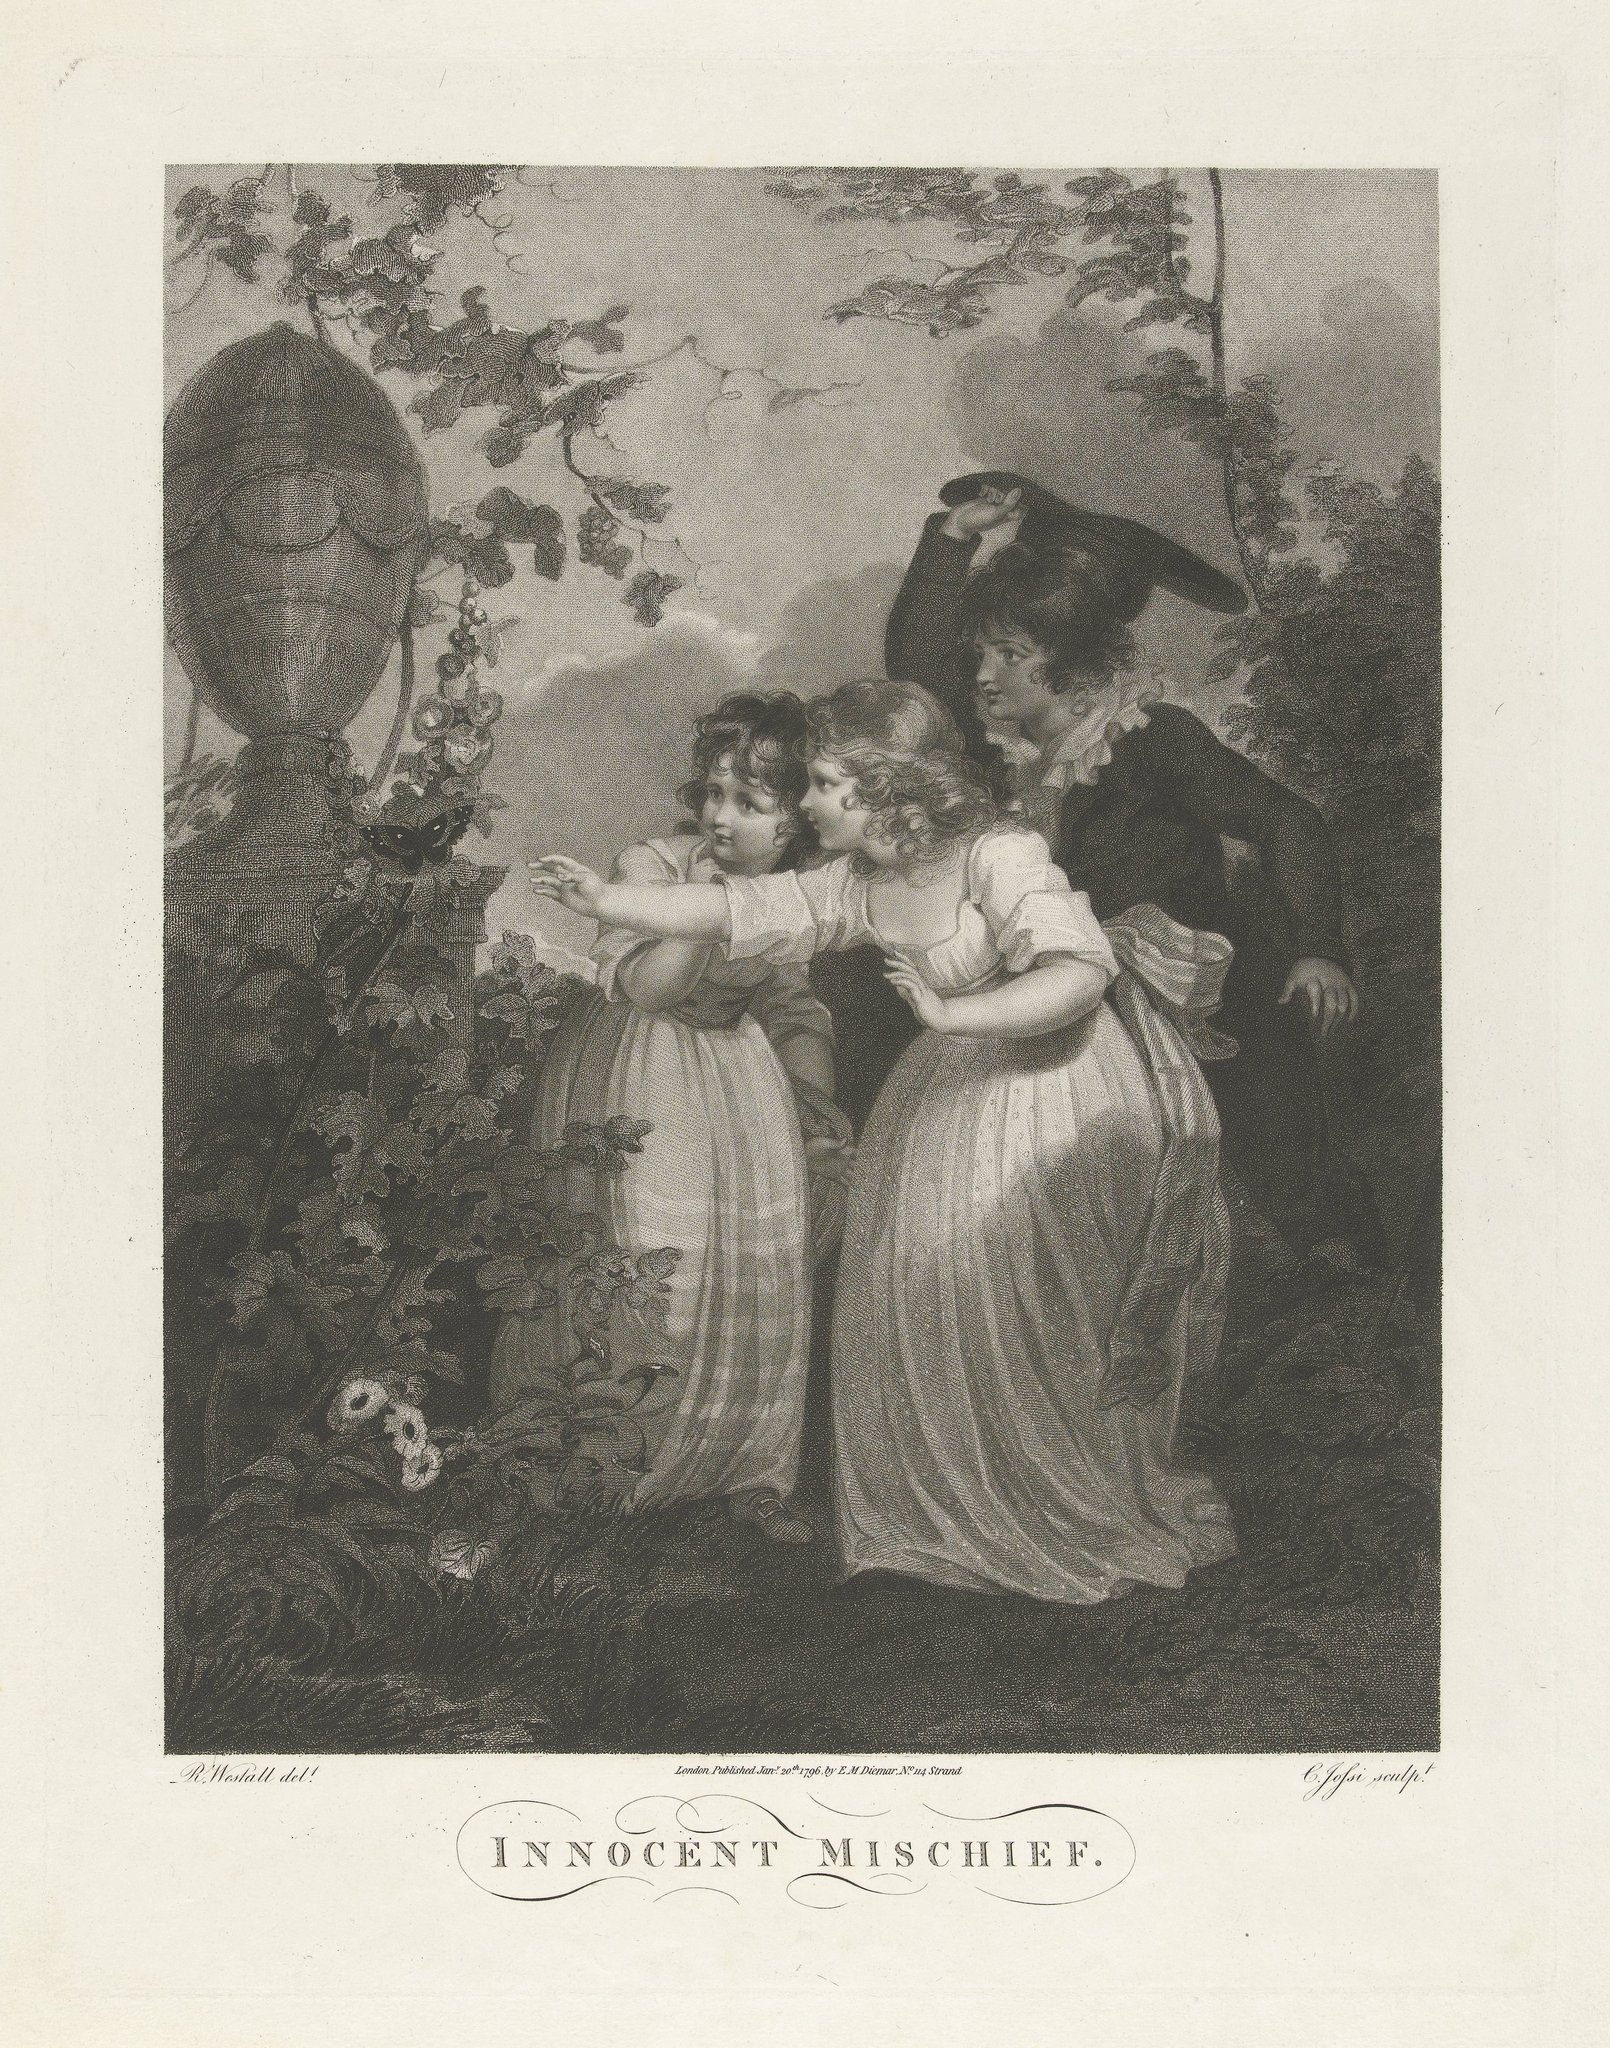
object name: print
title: Tuin met ondeugende kinderen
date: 1796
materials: paper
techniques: engraving, etching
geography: london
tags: mischief-making play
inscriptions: collector's mark: Lugt 2233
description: Een meisje probeert een vlinder te pakken, een ander meisje kijkt toe. Een jongen wil de vlinder verjagen.